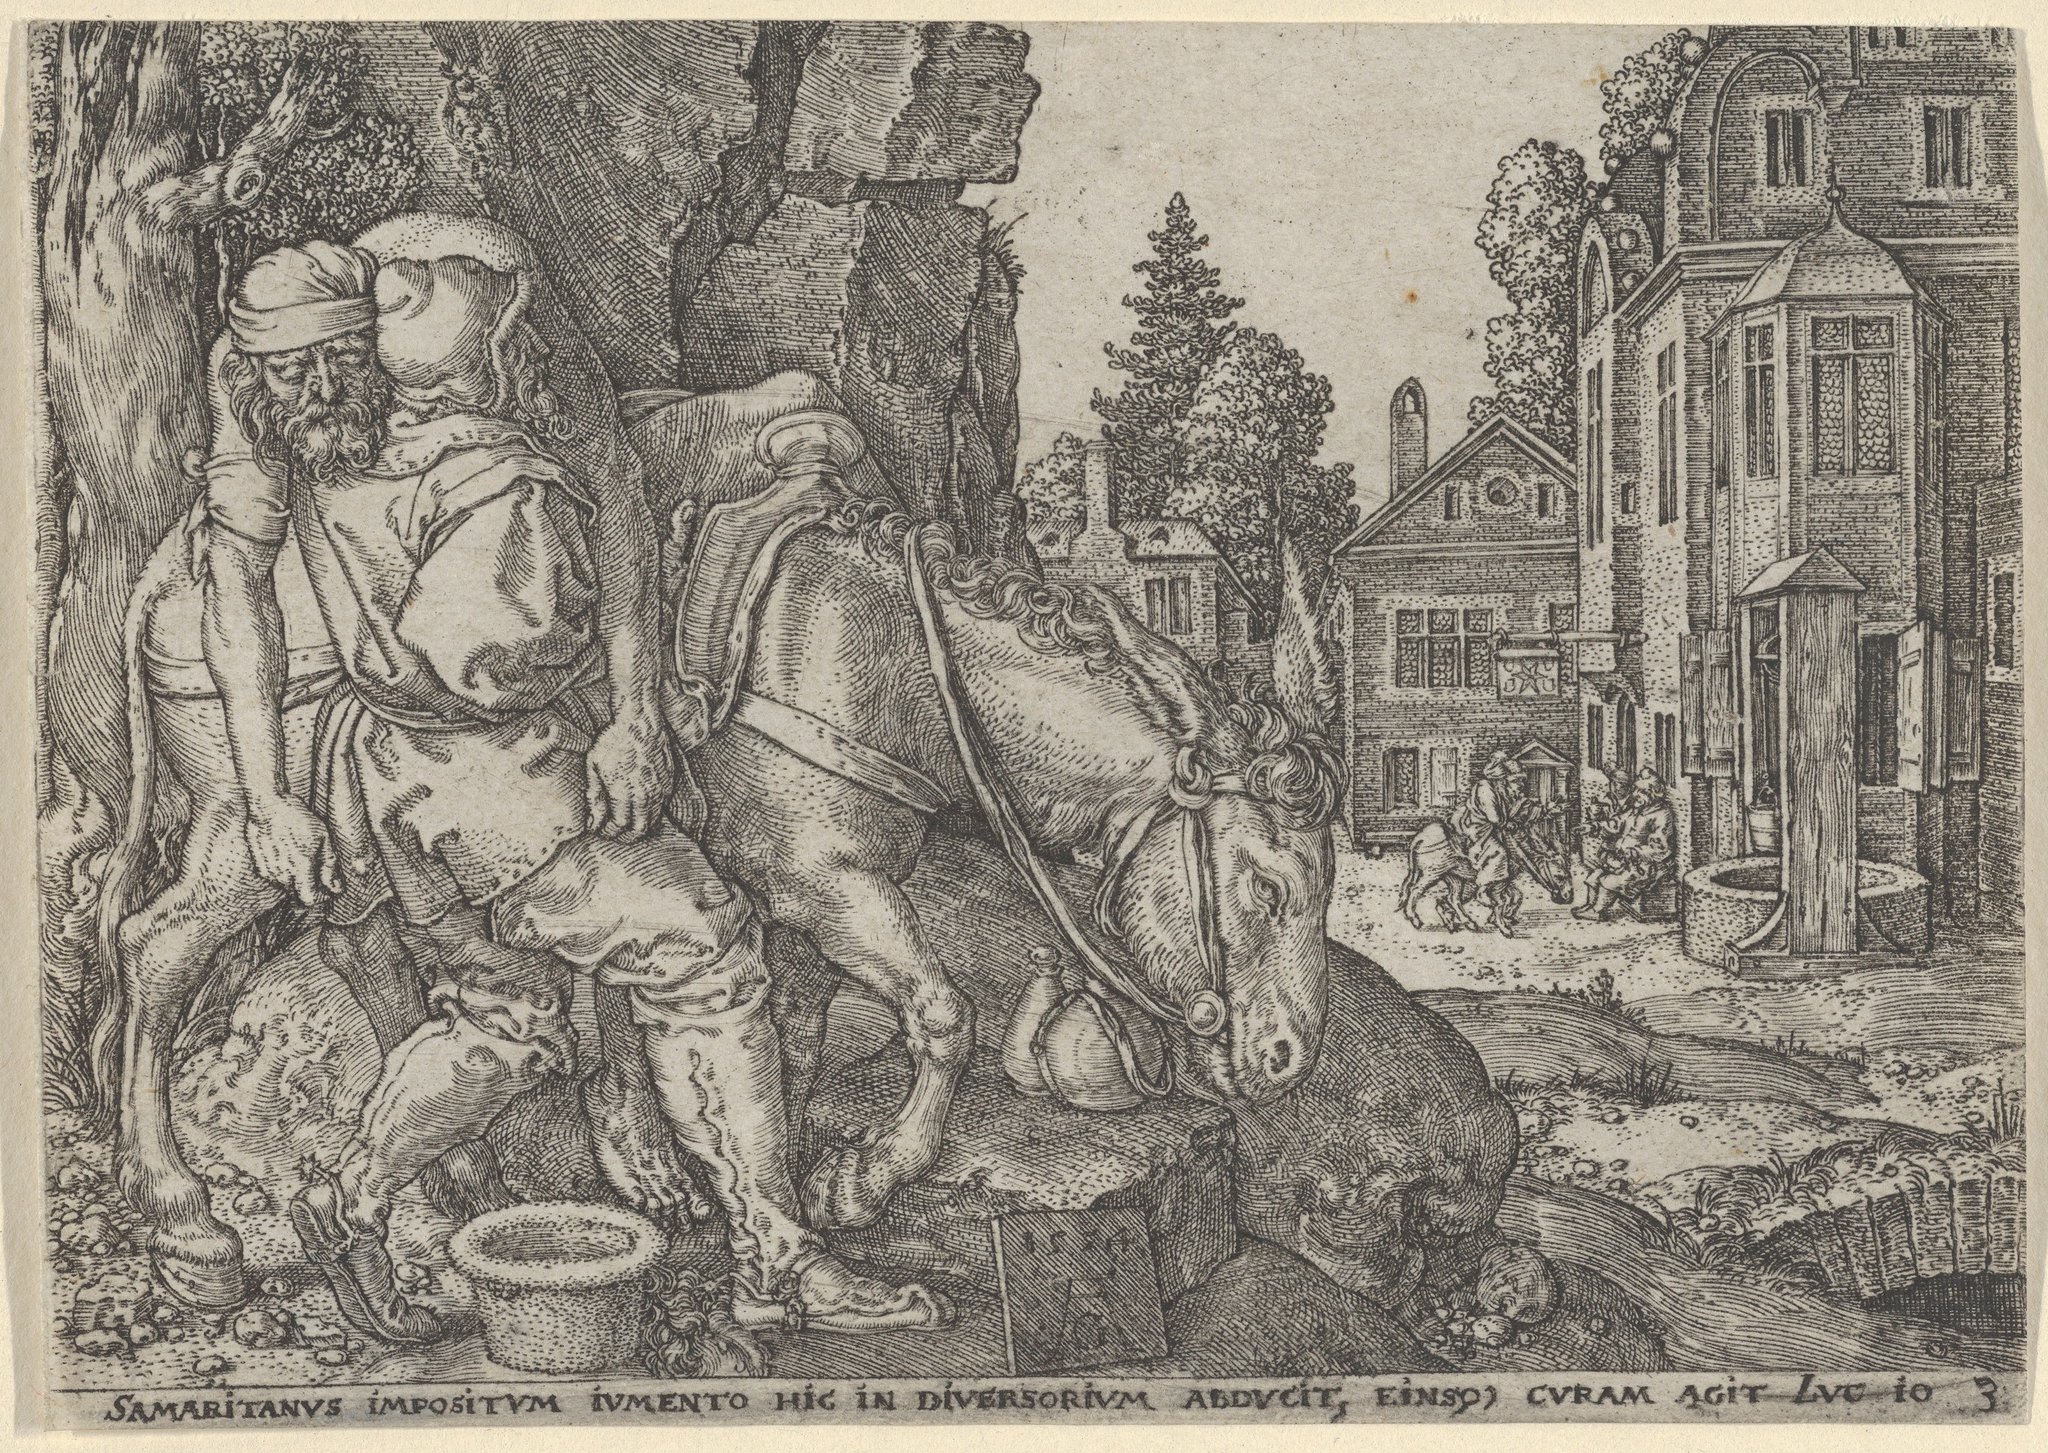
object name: print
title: The Good Samaritan Putting the Traveller on His Donkey, from "The Parable of the Good Samaritan"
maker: heinrich aldegrever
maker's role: artist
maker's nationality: german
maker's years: 1502-1561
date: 1554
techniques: engraving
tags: suffering,men,donkeys